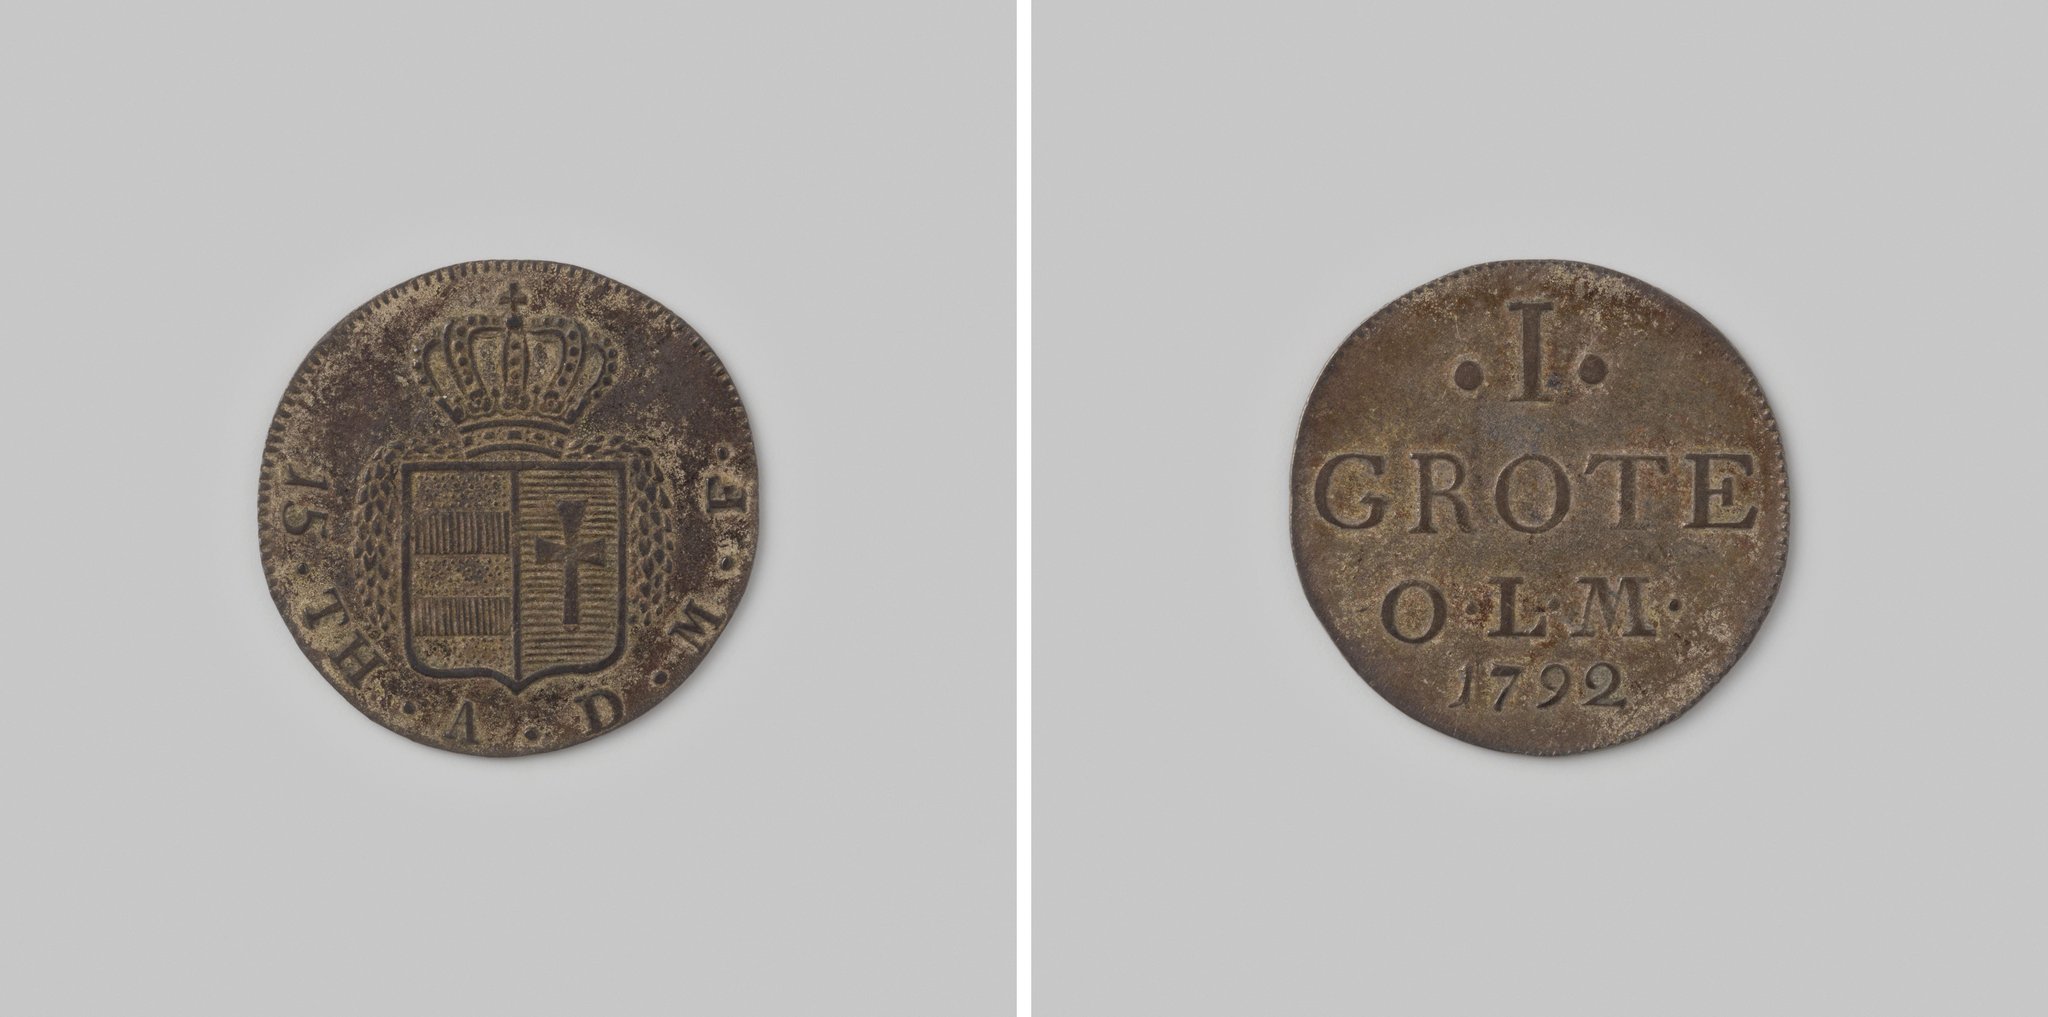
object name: coin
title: Hertogdom Oldenburg, Peter Friedrich Wilhelm, grote, 1792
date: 1792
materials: silver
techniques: striking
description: Zilveren munt. Voorzijde: gekroond versierd wapenschild. Keerzijde: waarde-aanduiding in twee regels, waaronder lands-aanduiding. Daaronder jaartal. Gladde rand.